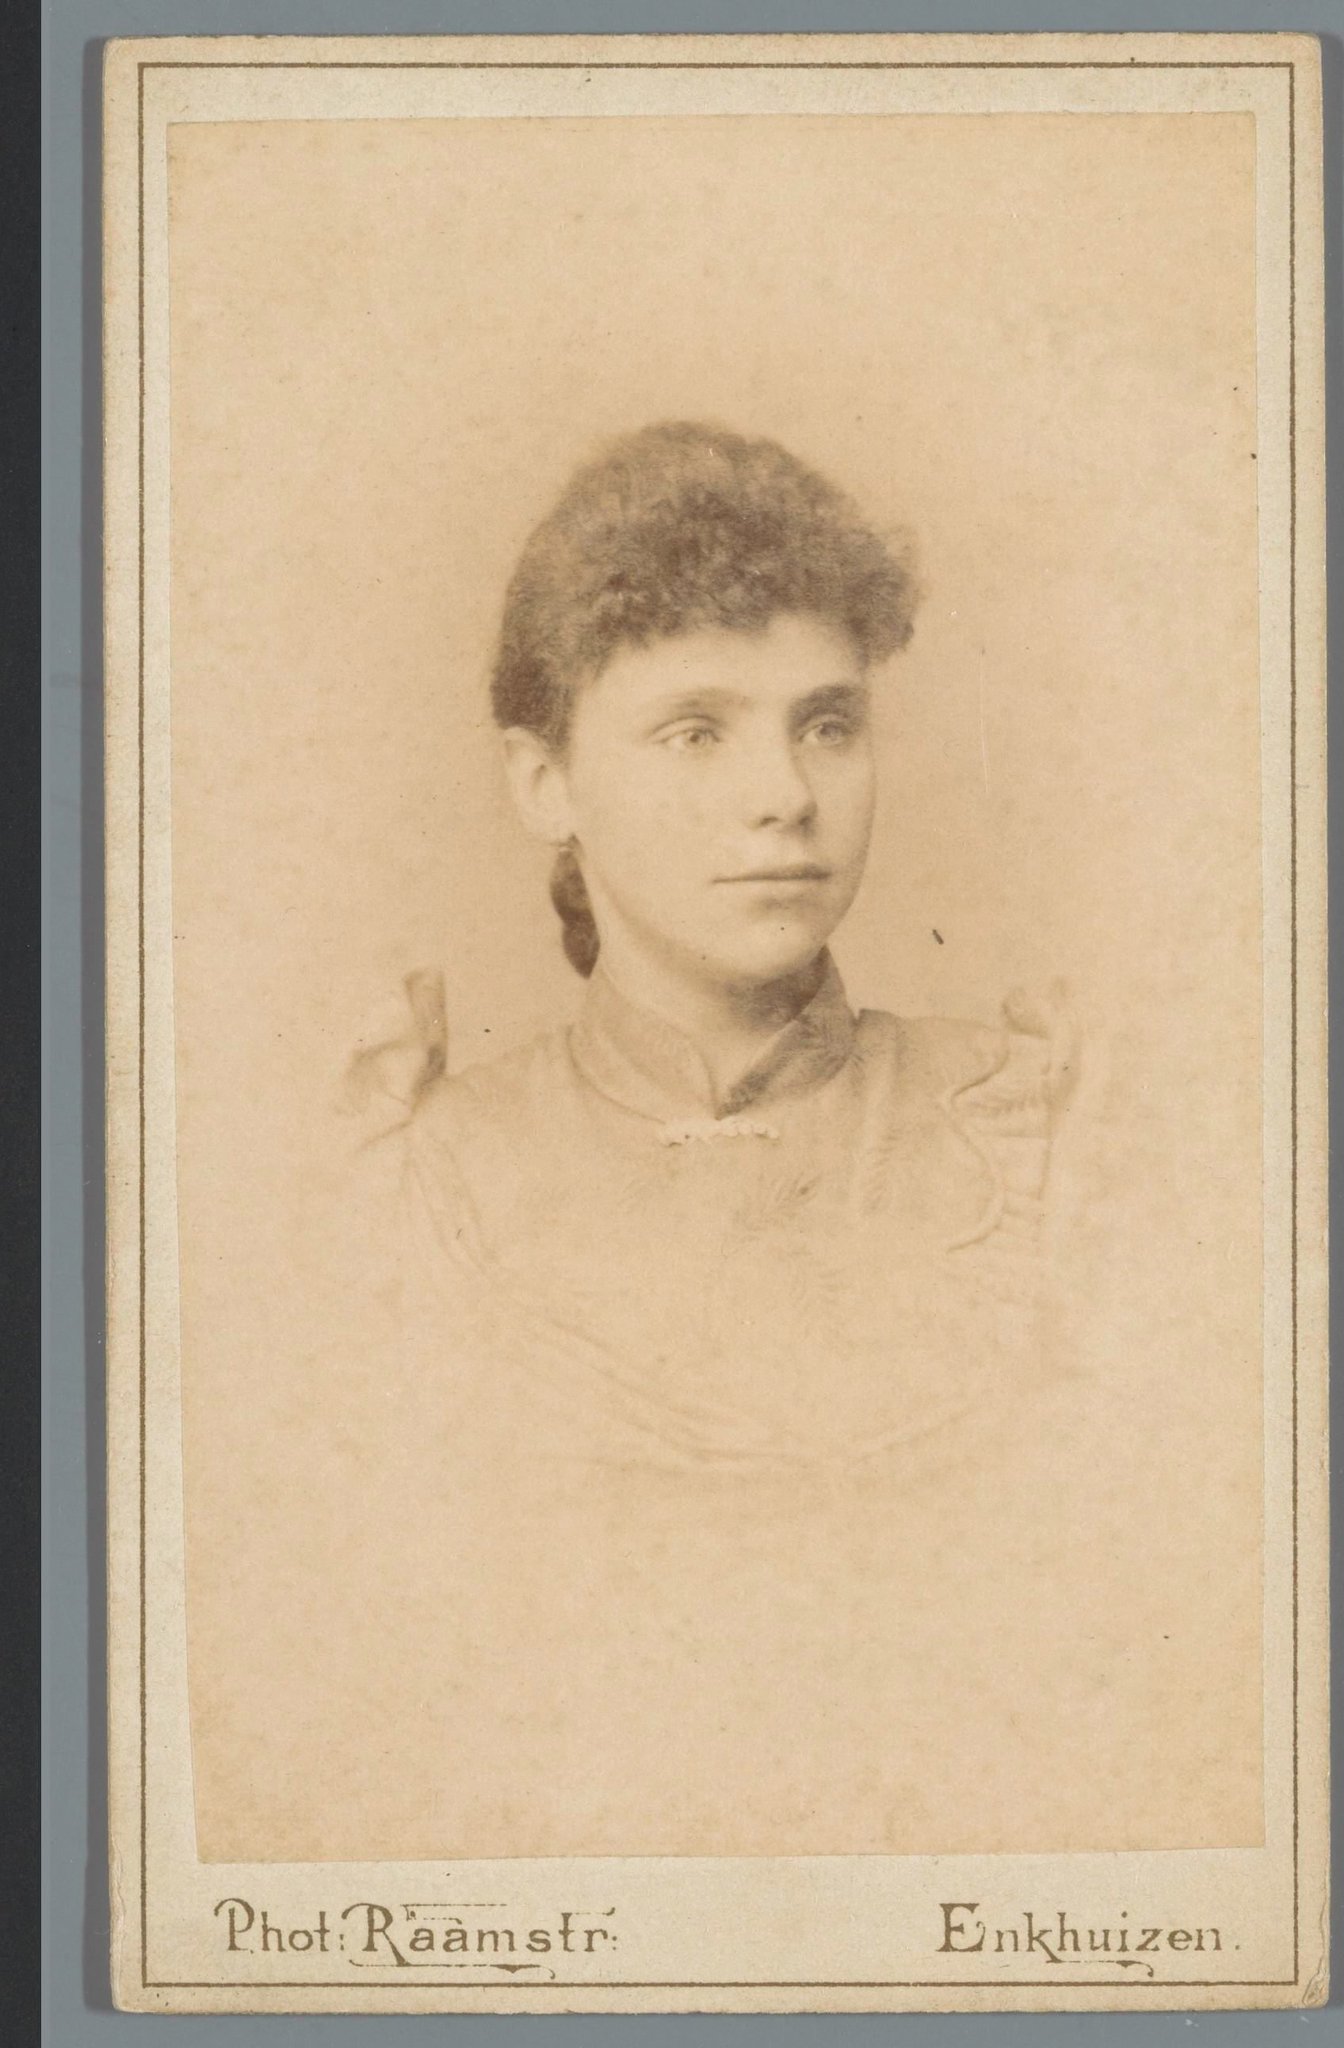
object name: photograph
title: Portret van een onbekende vrouw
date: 1880-1900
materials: cardboard, paper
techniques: albumen print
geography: enkhuizen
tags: historical persons - bb - woman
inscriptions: inscription: ‘Raamstraat/ o/h Diaconiehuis/ Photographisch Atelier/ ENKHUIZEN.’